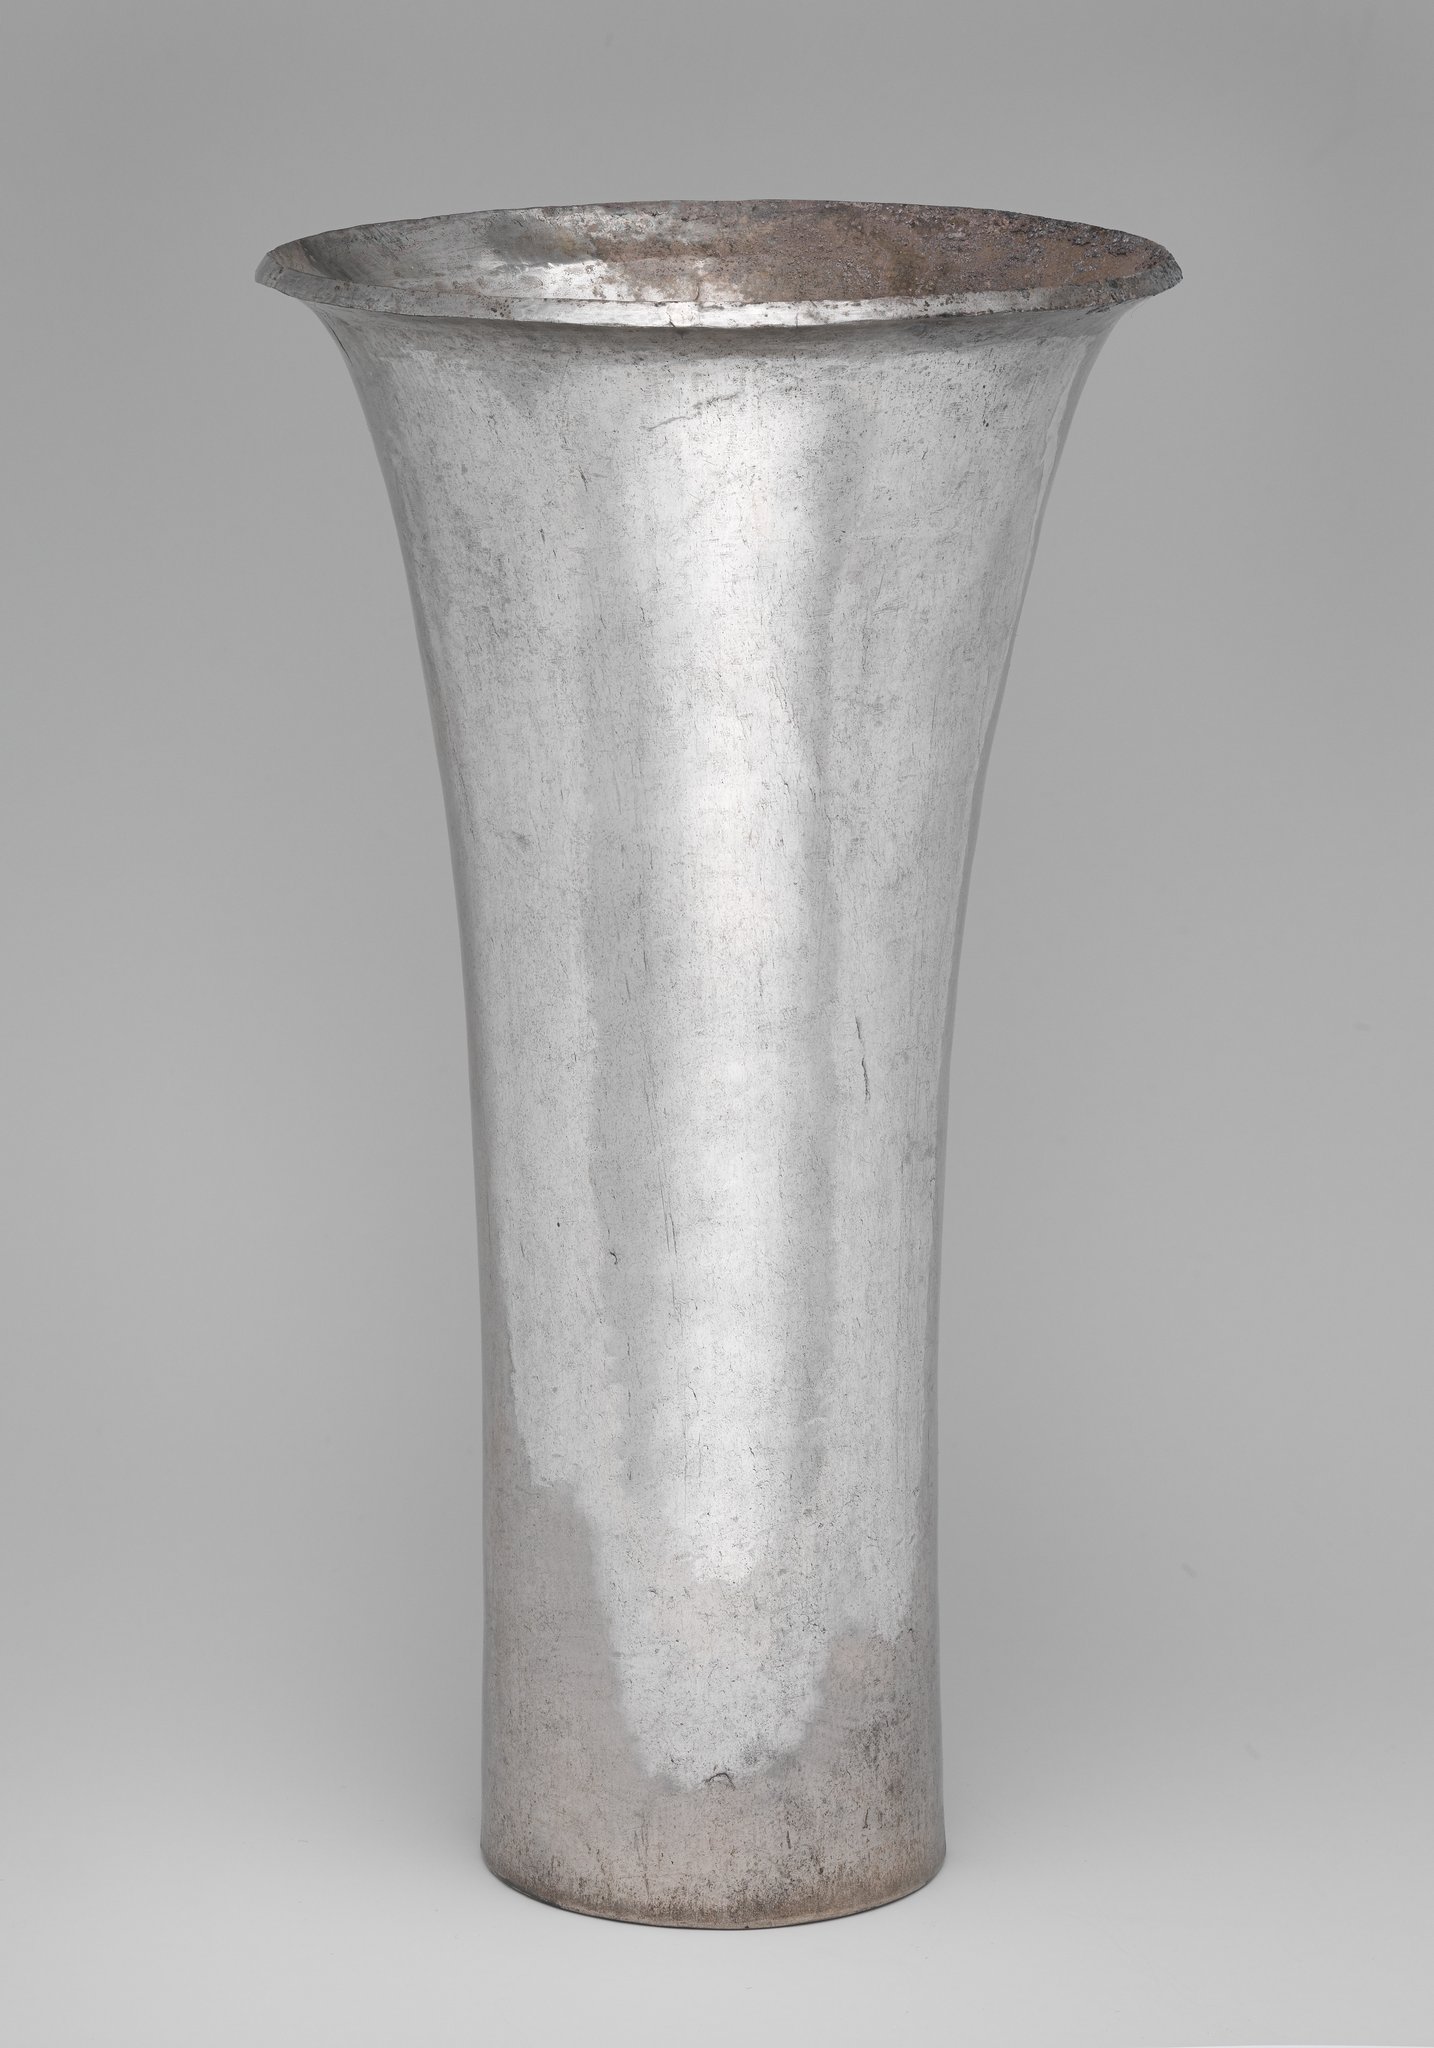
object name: beaker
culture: chimú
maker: chimú artist(s)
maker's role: artist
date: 1300-1470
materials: silver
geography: peru